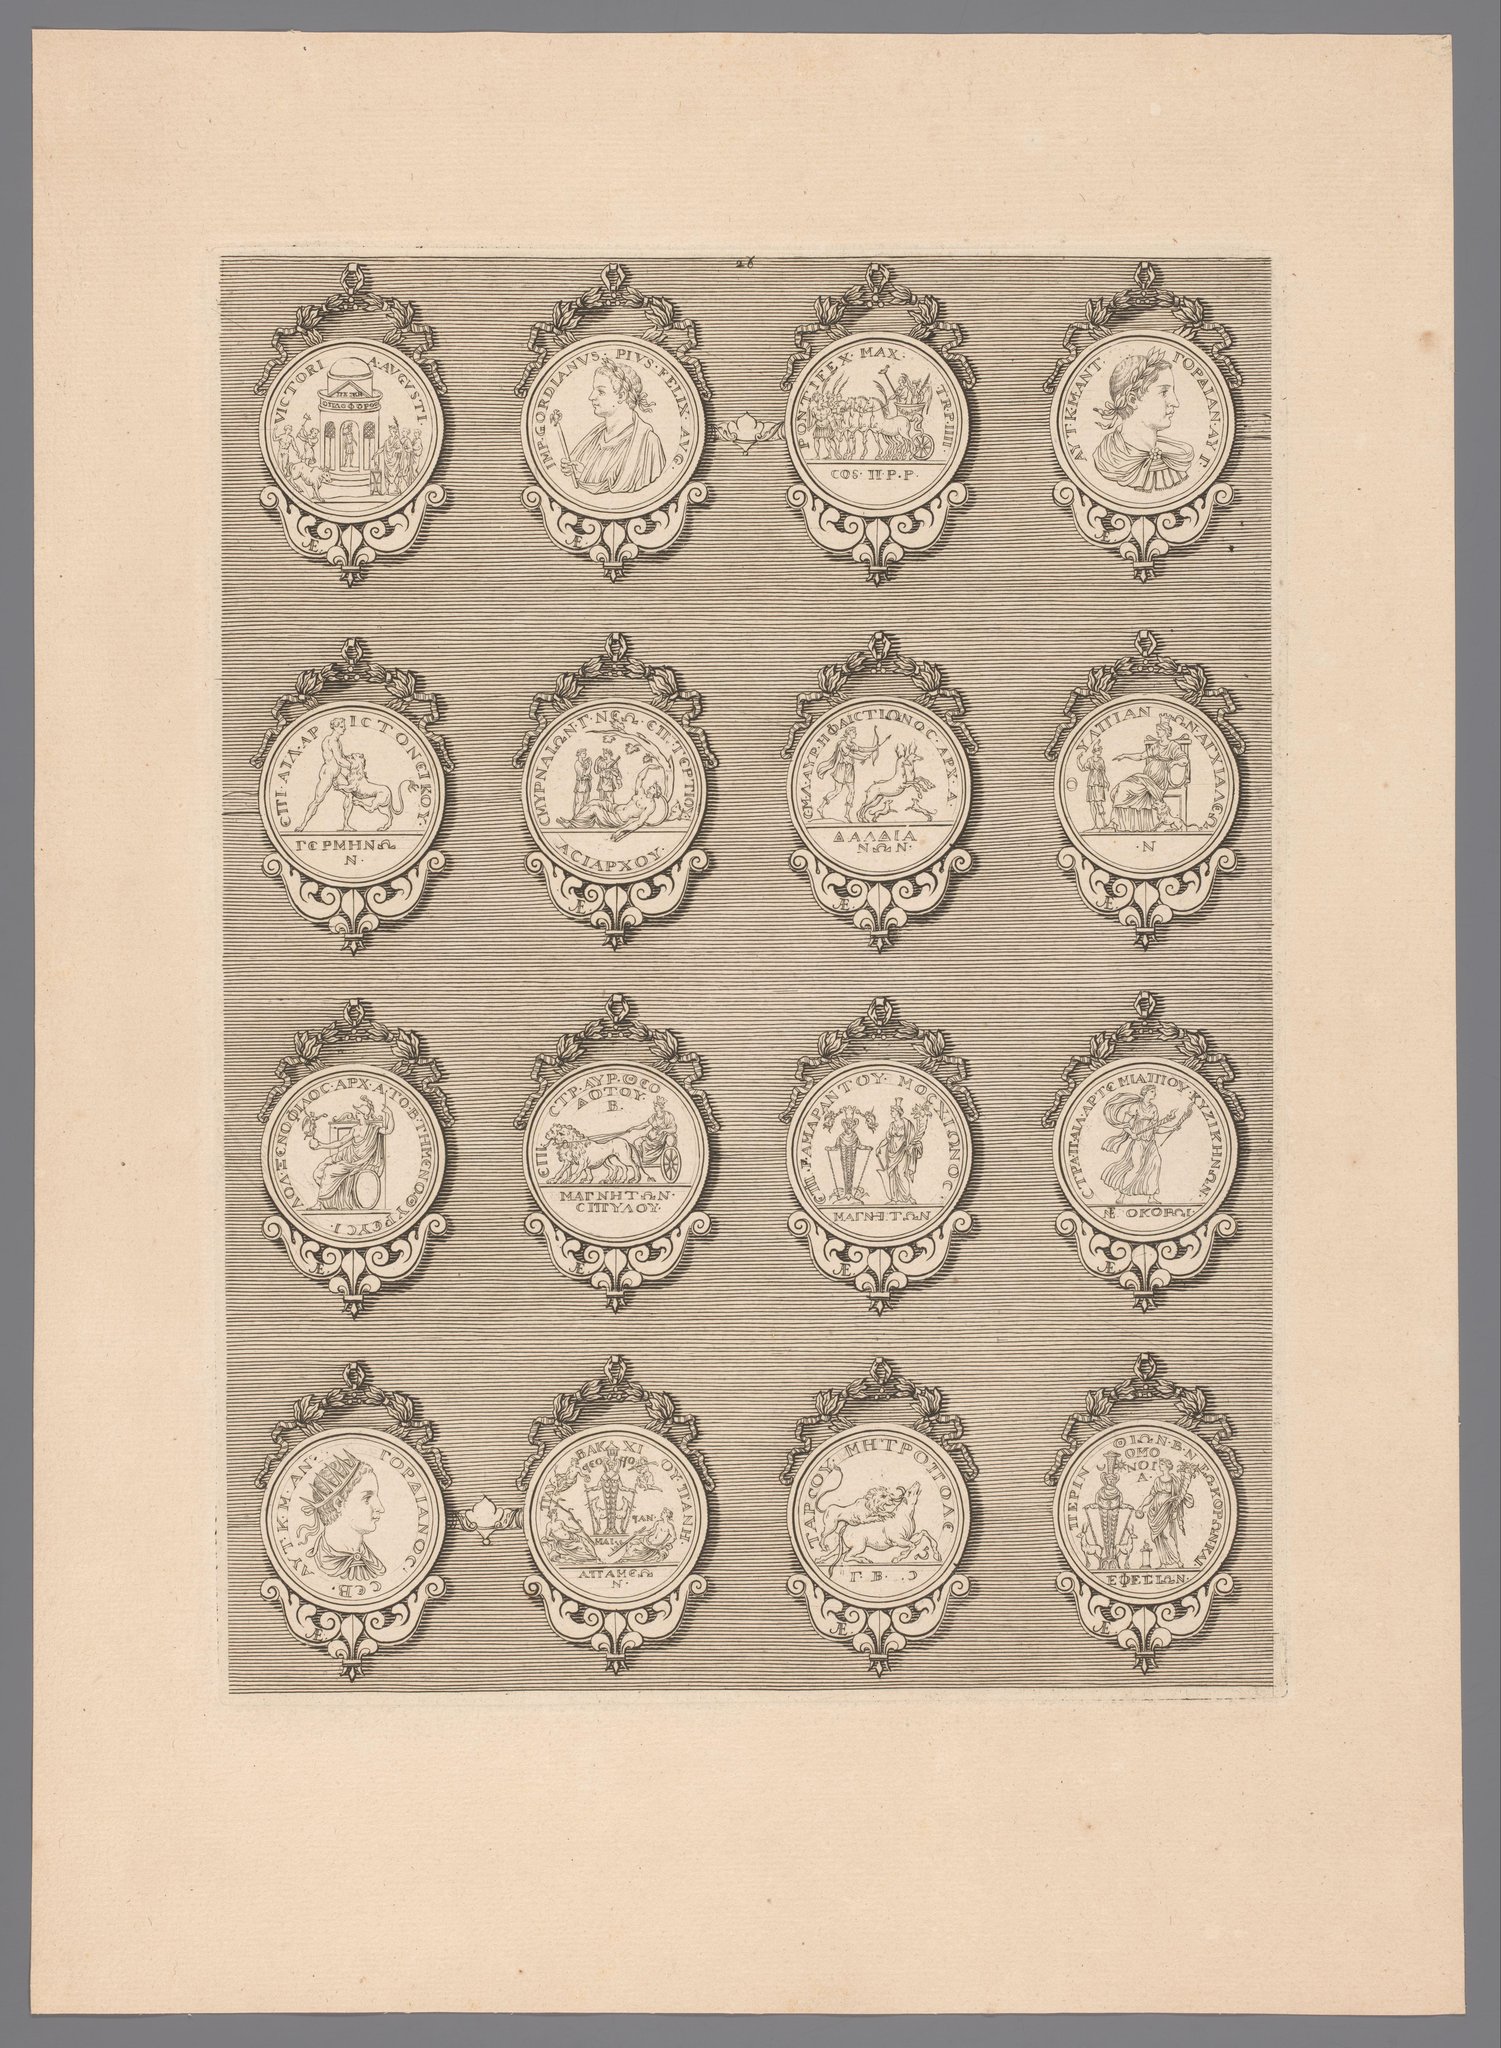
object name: print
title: Penningen in versierde lijsten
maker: simon de la boissière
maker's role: print maker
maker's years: 1637-1682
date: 1647-1682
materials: paper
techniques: etching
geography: france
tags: medal (considered as a piece of sculpture, regardless of its specific function)